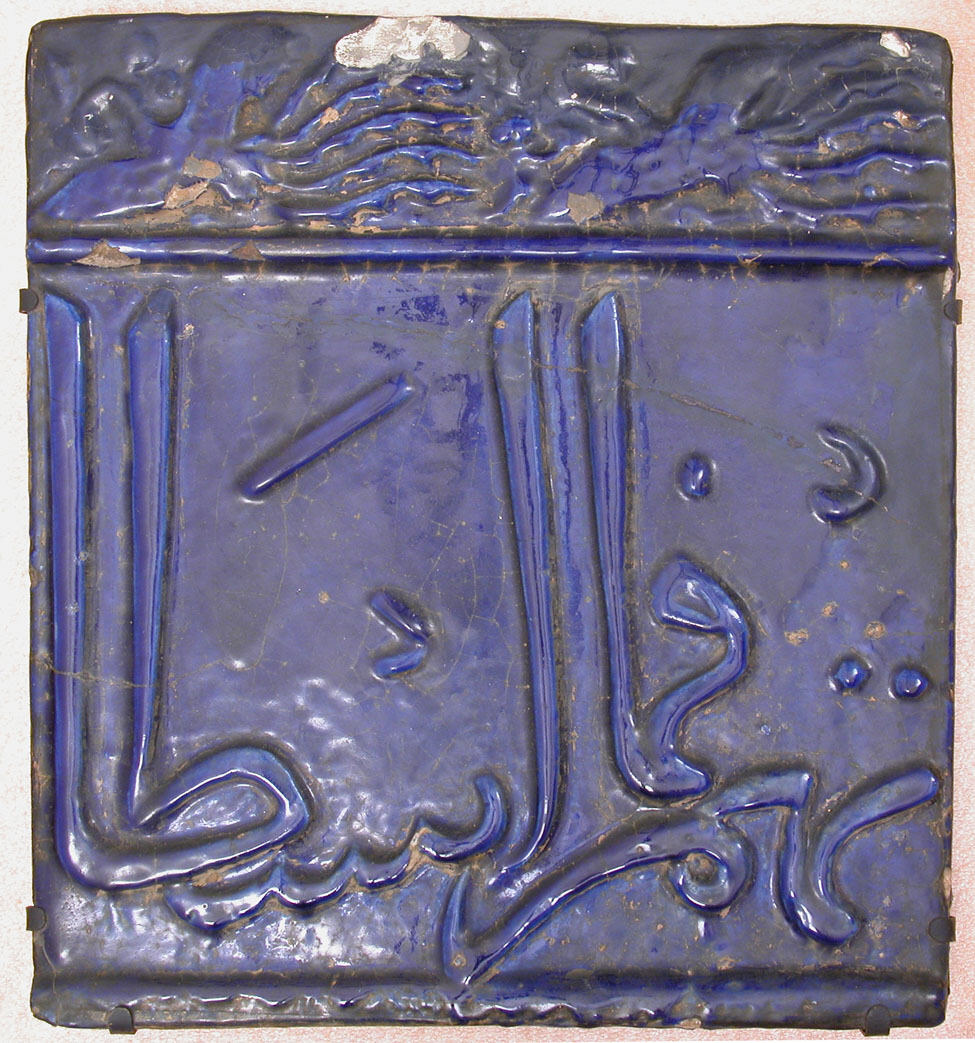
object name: tile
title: Tile from a Frieze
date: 1301-1333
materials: stonepaste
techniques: glazing, molding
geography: iran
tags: birds